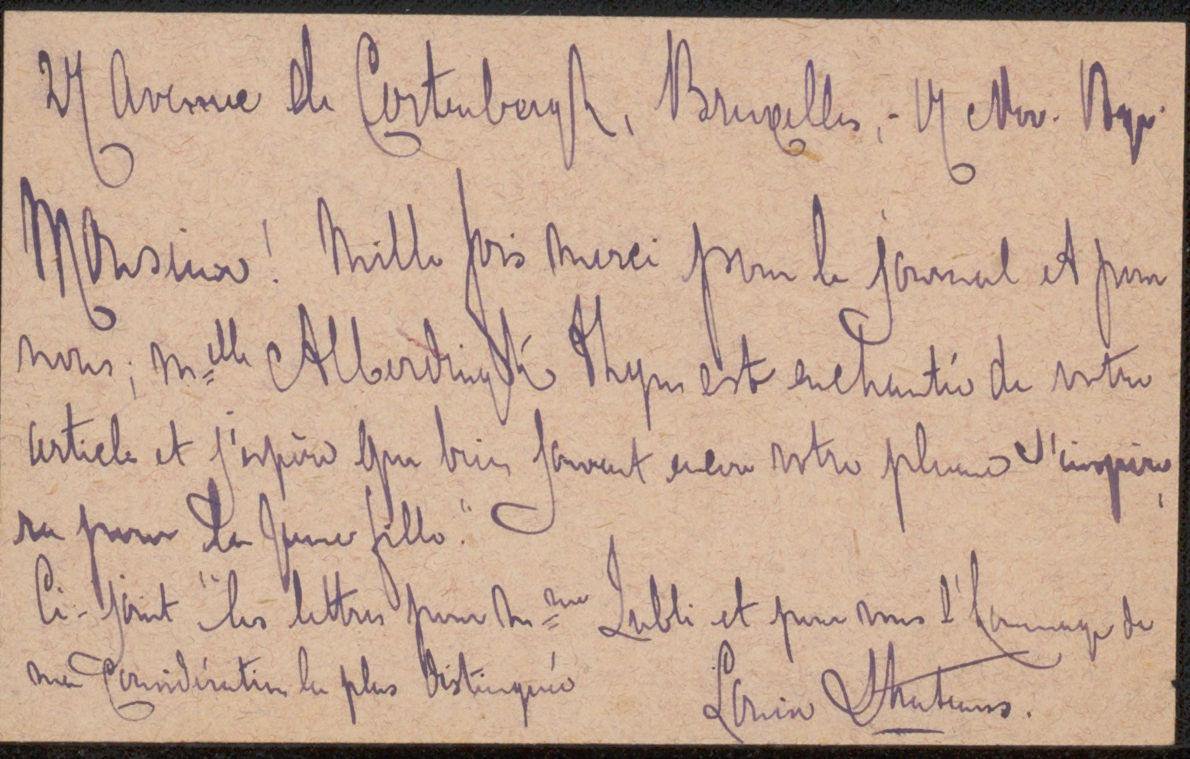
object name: visiting card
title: Visitekaartje aan Philip Zilcken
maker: louise stratenus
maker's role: schrijver, vertaler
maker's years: 1852-1908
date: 1890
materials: cardboard, ink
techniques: pen, printing, writing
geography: brussels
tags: amsterdam, catharina alberdingk thijm, leiden, maria zubli-van den berch van heemstede, the hague, painter, draughtsman, philip zilcken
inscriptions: collector's mark: ‘RPK’